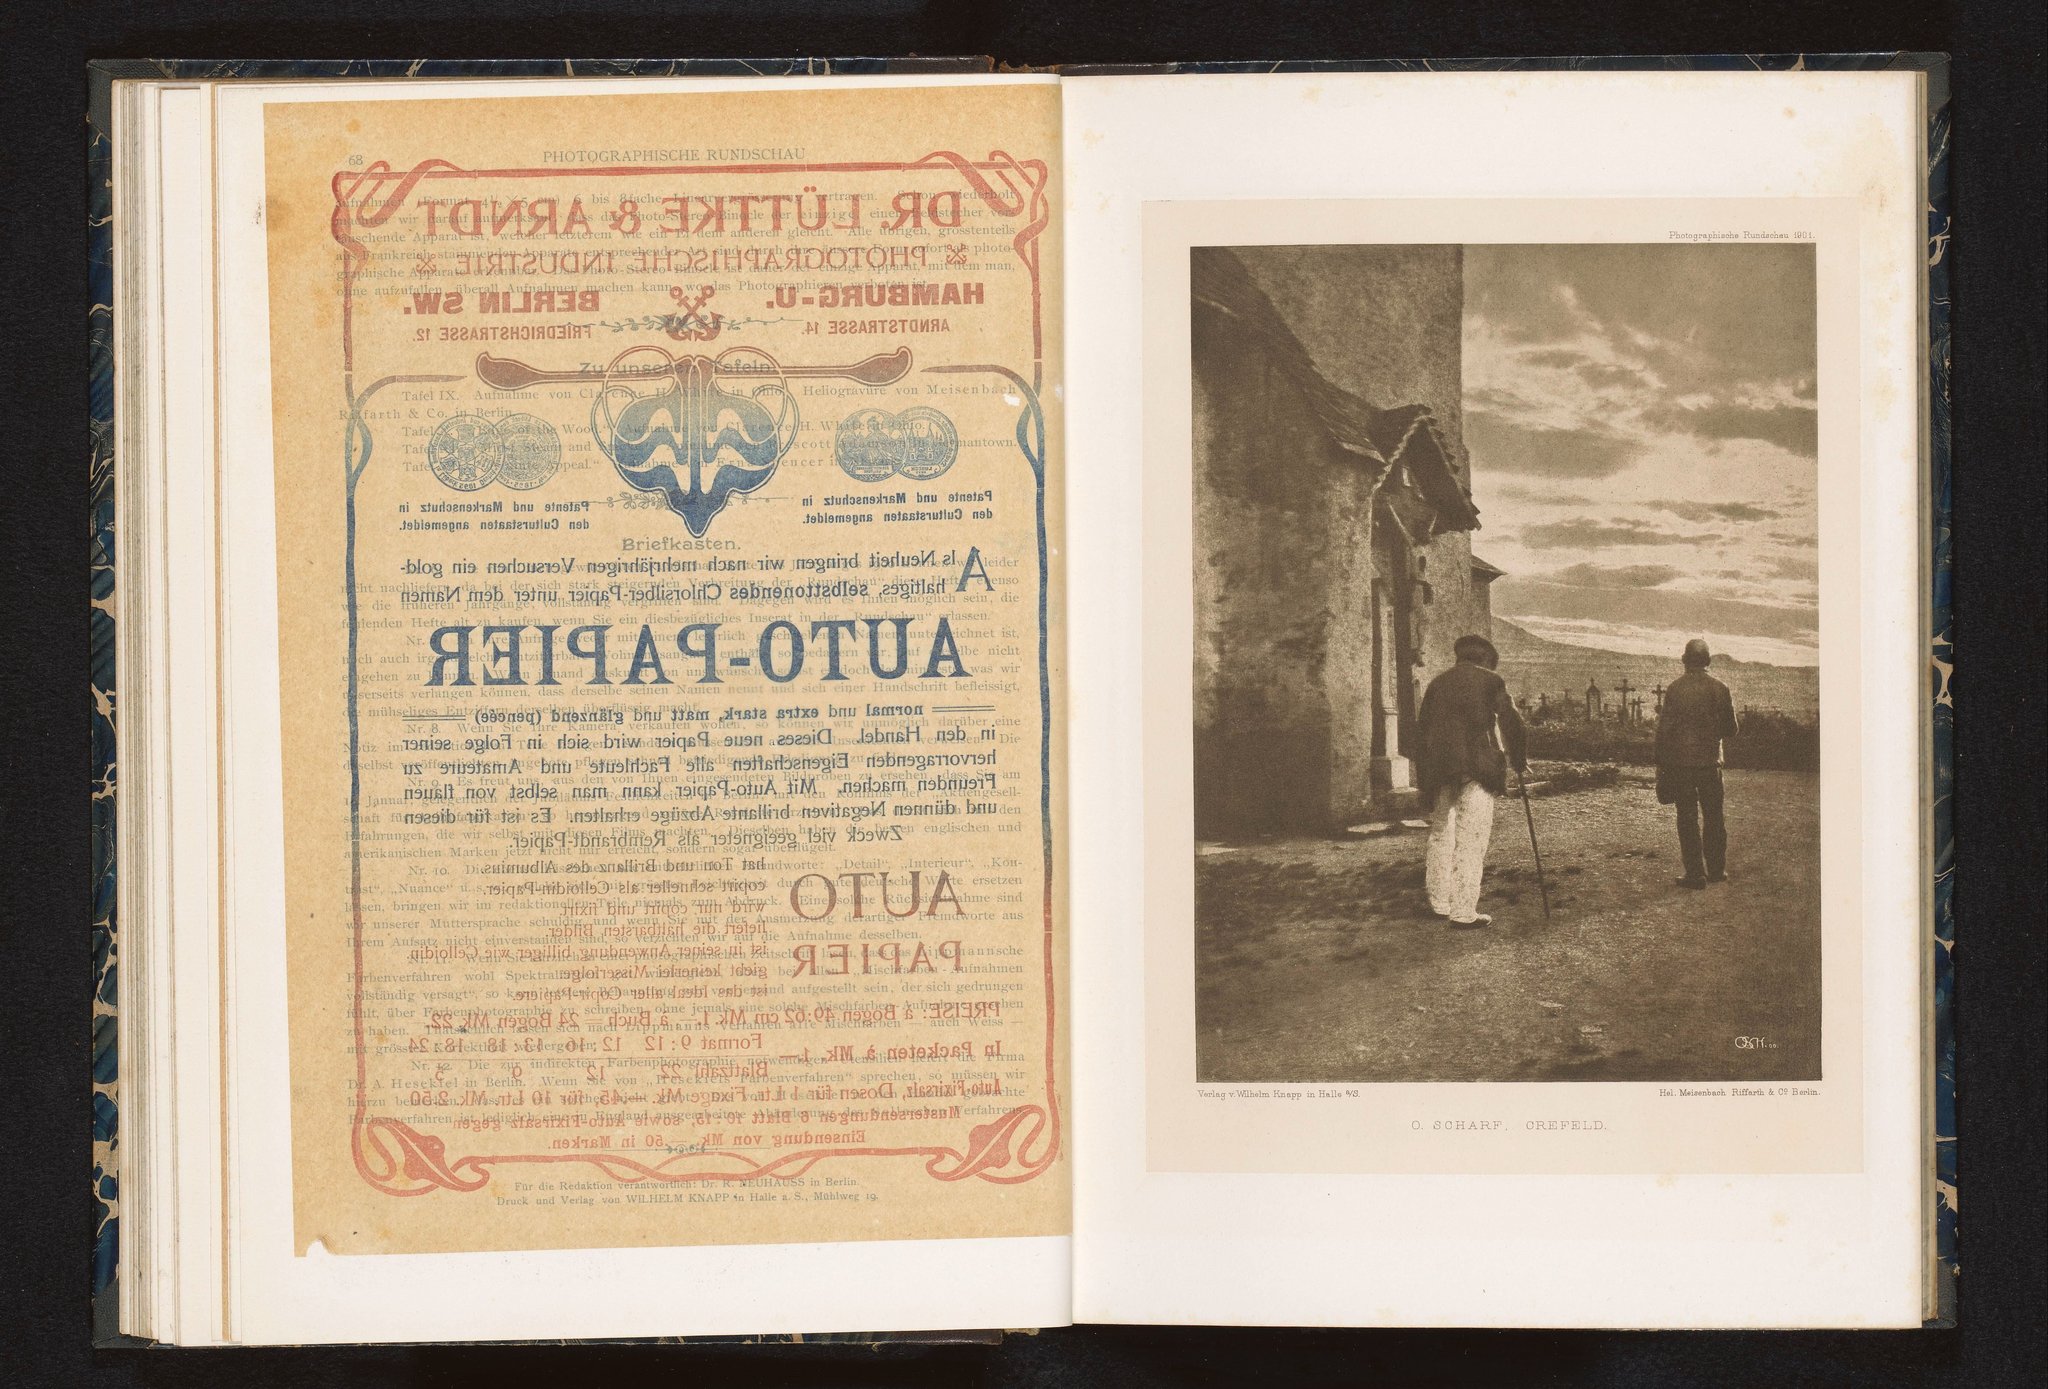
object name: photomechanical print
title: Twee mannen naast een kerk, met op de achtergrond een begraafplaats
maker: otto scharf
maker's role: fotograaf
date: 1900-1901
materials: paper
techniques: photoaquatint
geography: halle an der saale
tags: adult man, church (exterior), churchyard, cemetery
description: Prent op tweede ongenummerde pagina na pagina 68.